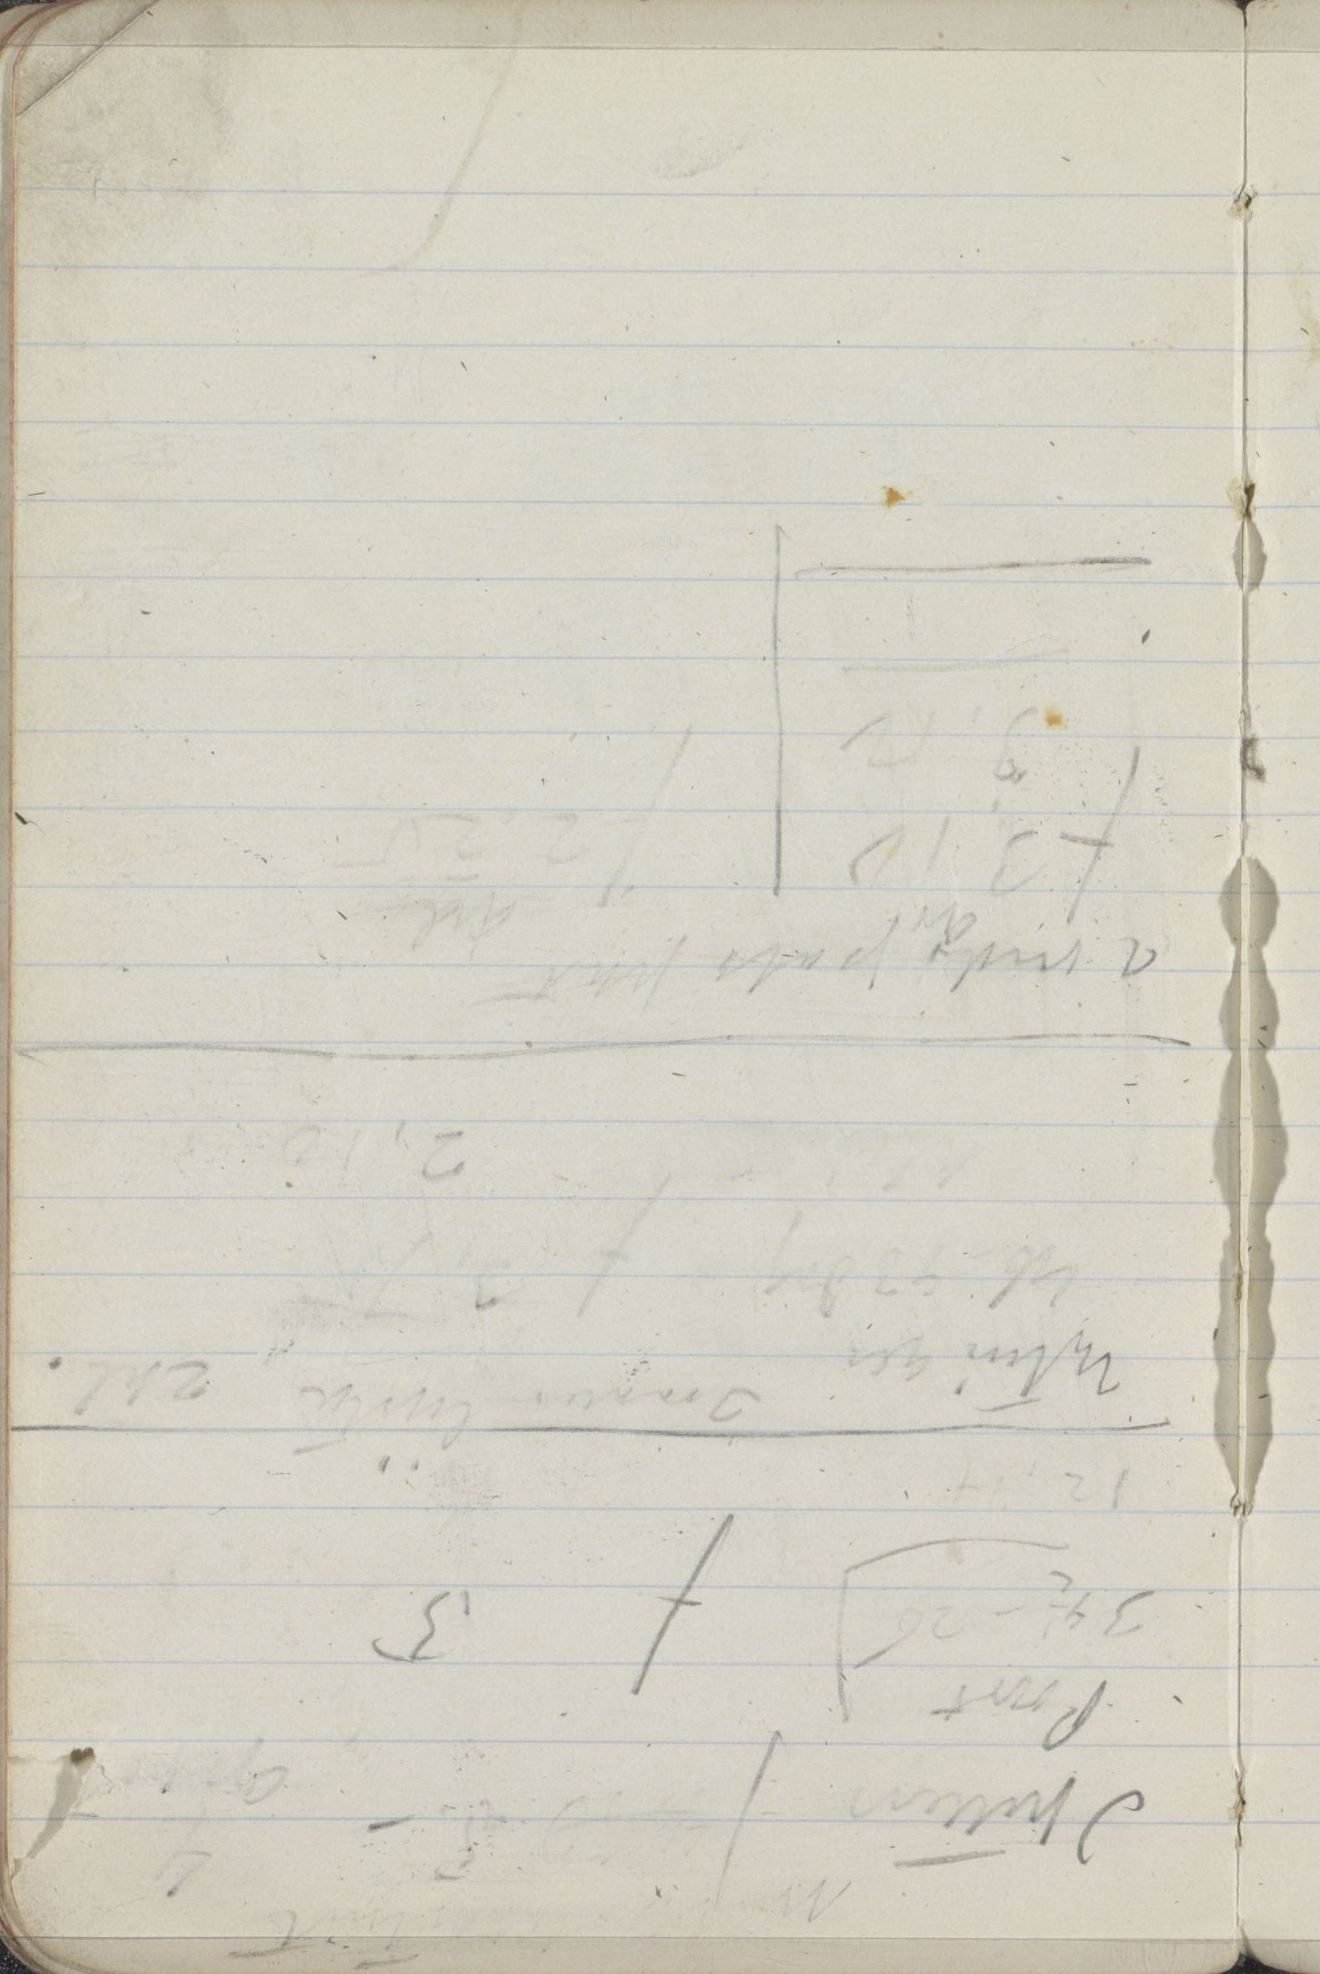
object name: sketchbook leaf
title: Annotaties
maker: george hendrik breitner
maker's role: draughtsman, painter, print maker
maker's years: 1857-1923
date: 1890-1900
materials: pencil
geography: amsterdam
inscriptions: annotation: ‘[...]’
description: Pagina 63 uit een schetsboek met 33 bladen.